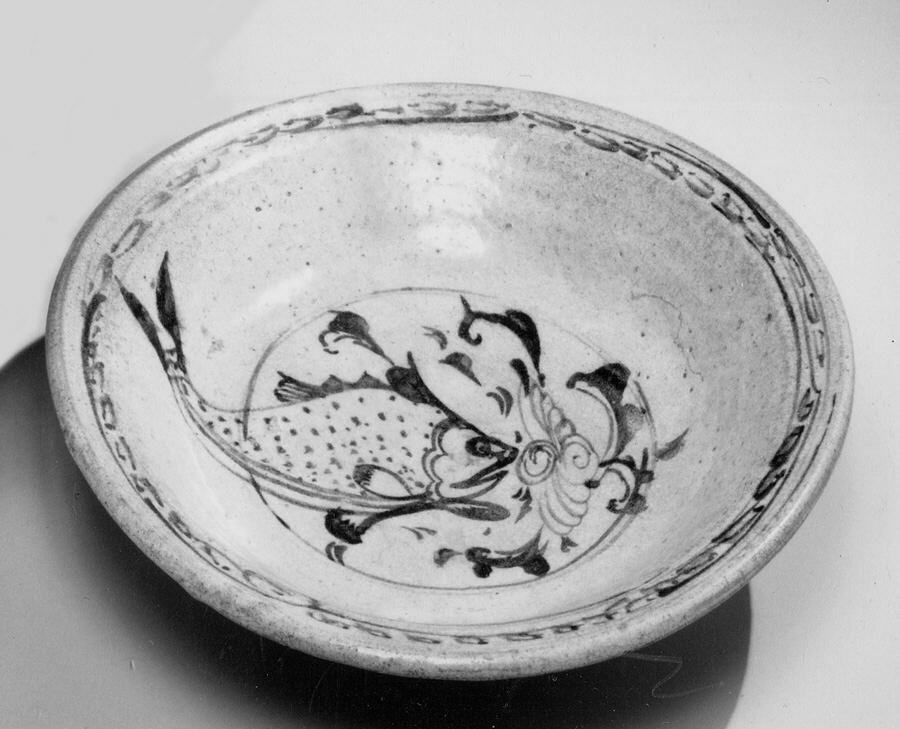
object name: dish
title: Dish with Fish Design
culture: thai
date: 1401-1600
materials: earthenware, glaze, iron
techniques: underglaze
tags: fish